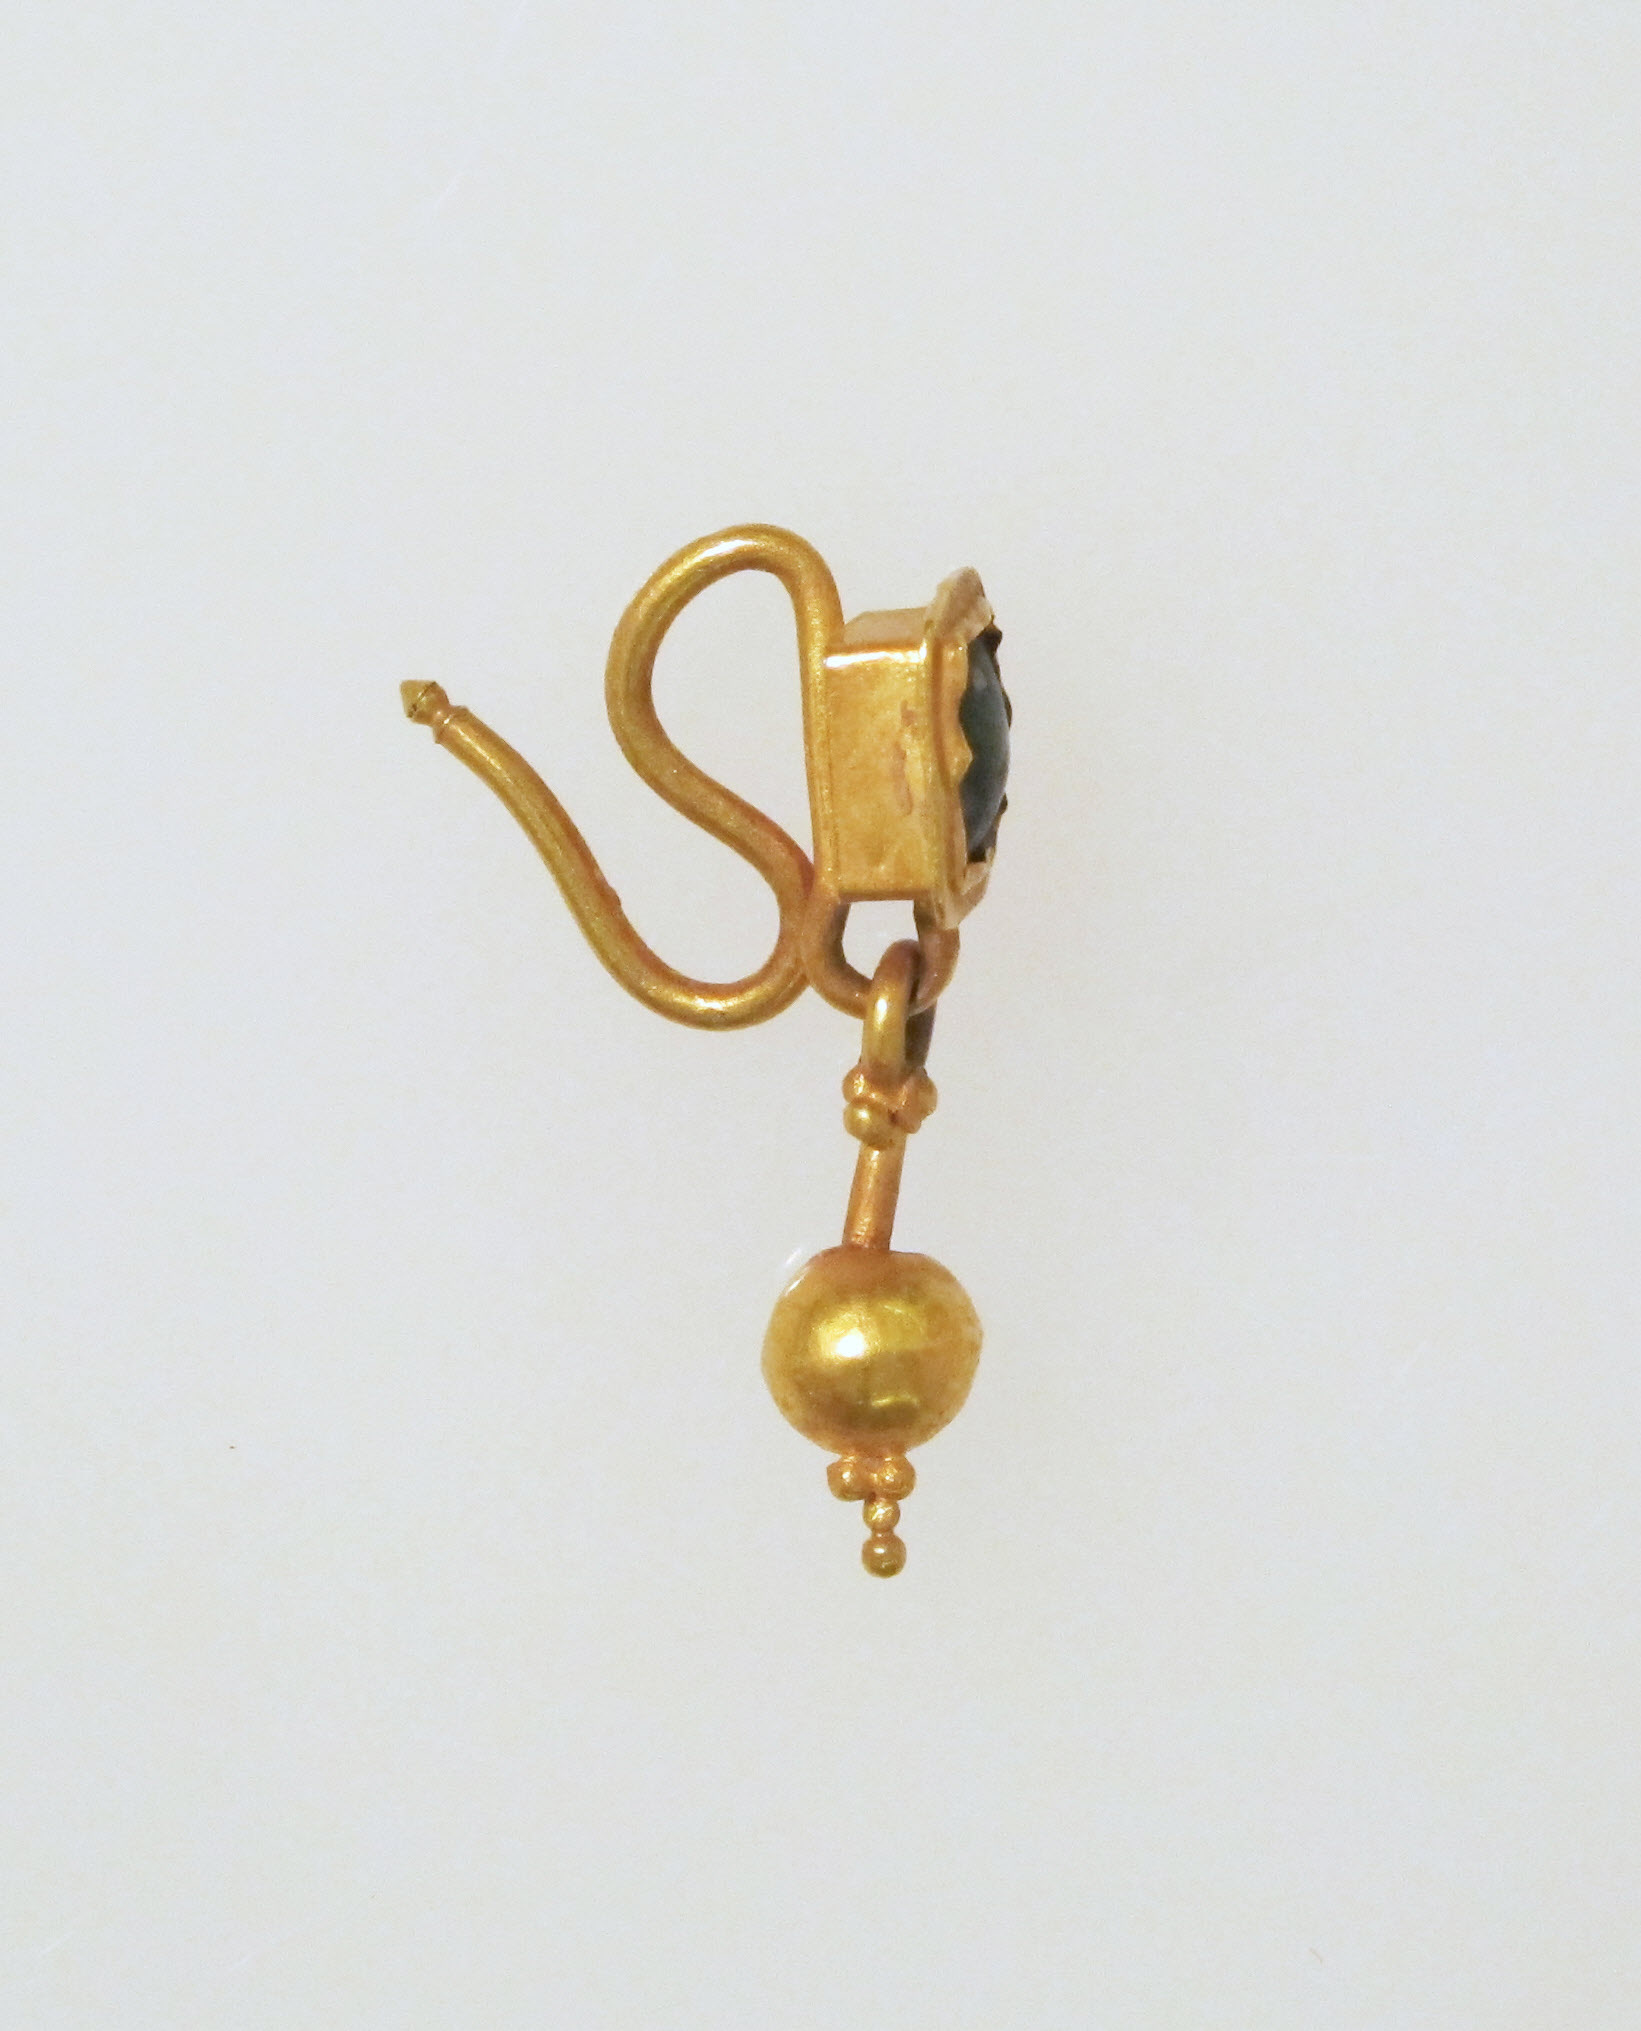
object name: earring hook type with pendant and paste setting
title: Earring-hook type with pendants and paste setting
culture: roman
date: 101-200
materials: glass, gold, paste